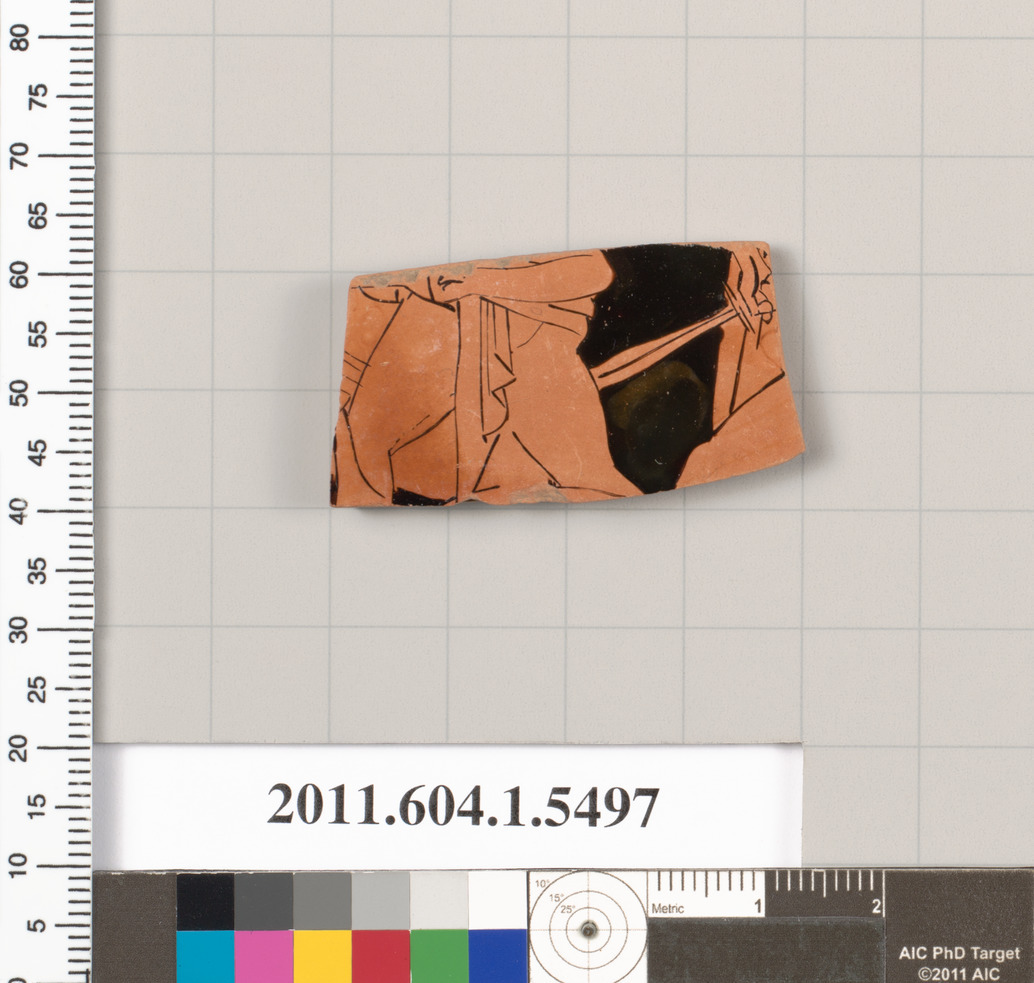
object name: kylix fragment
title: Terracotta fragment of a kylix (drinking cup)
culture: greek, attic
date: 500-480 BCE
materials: terracotta